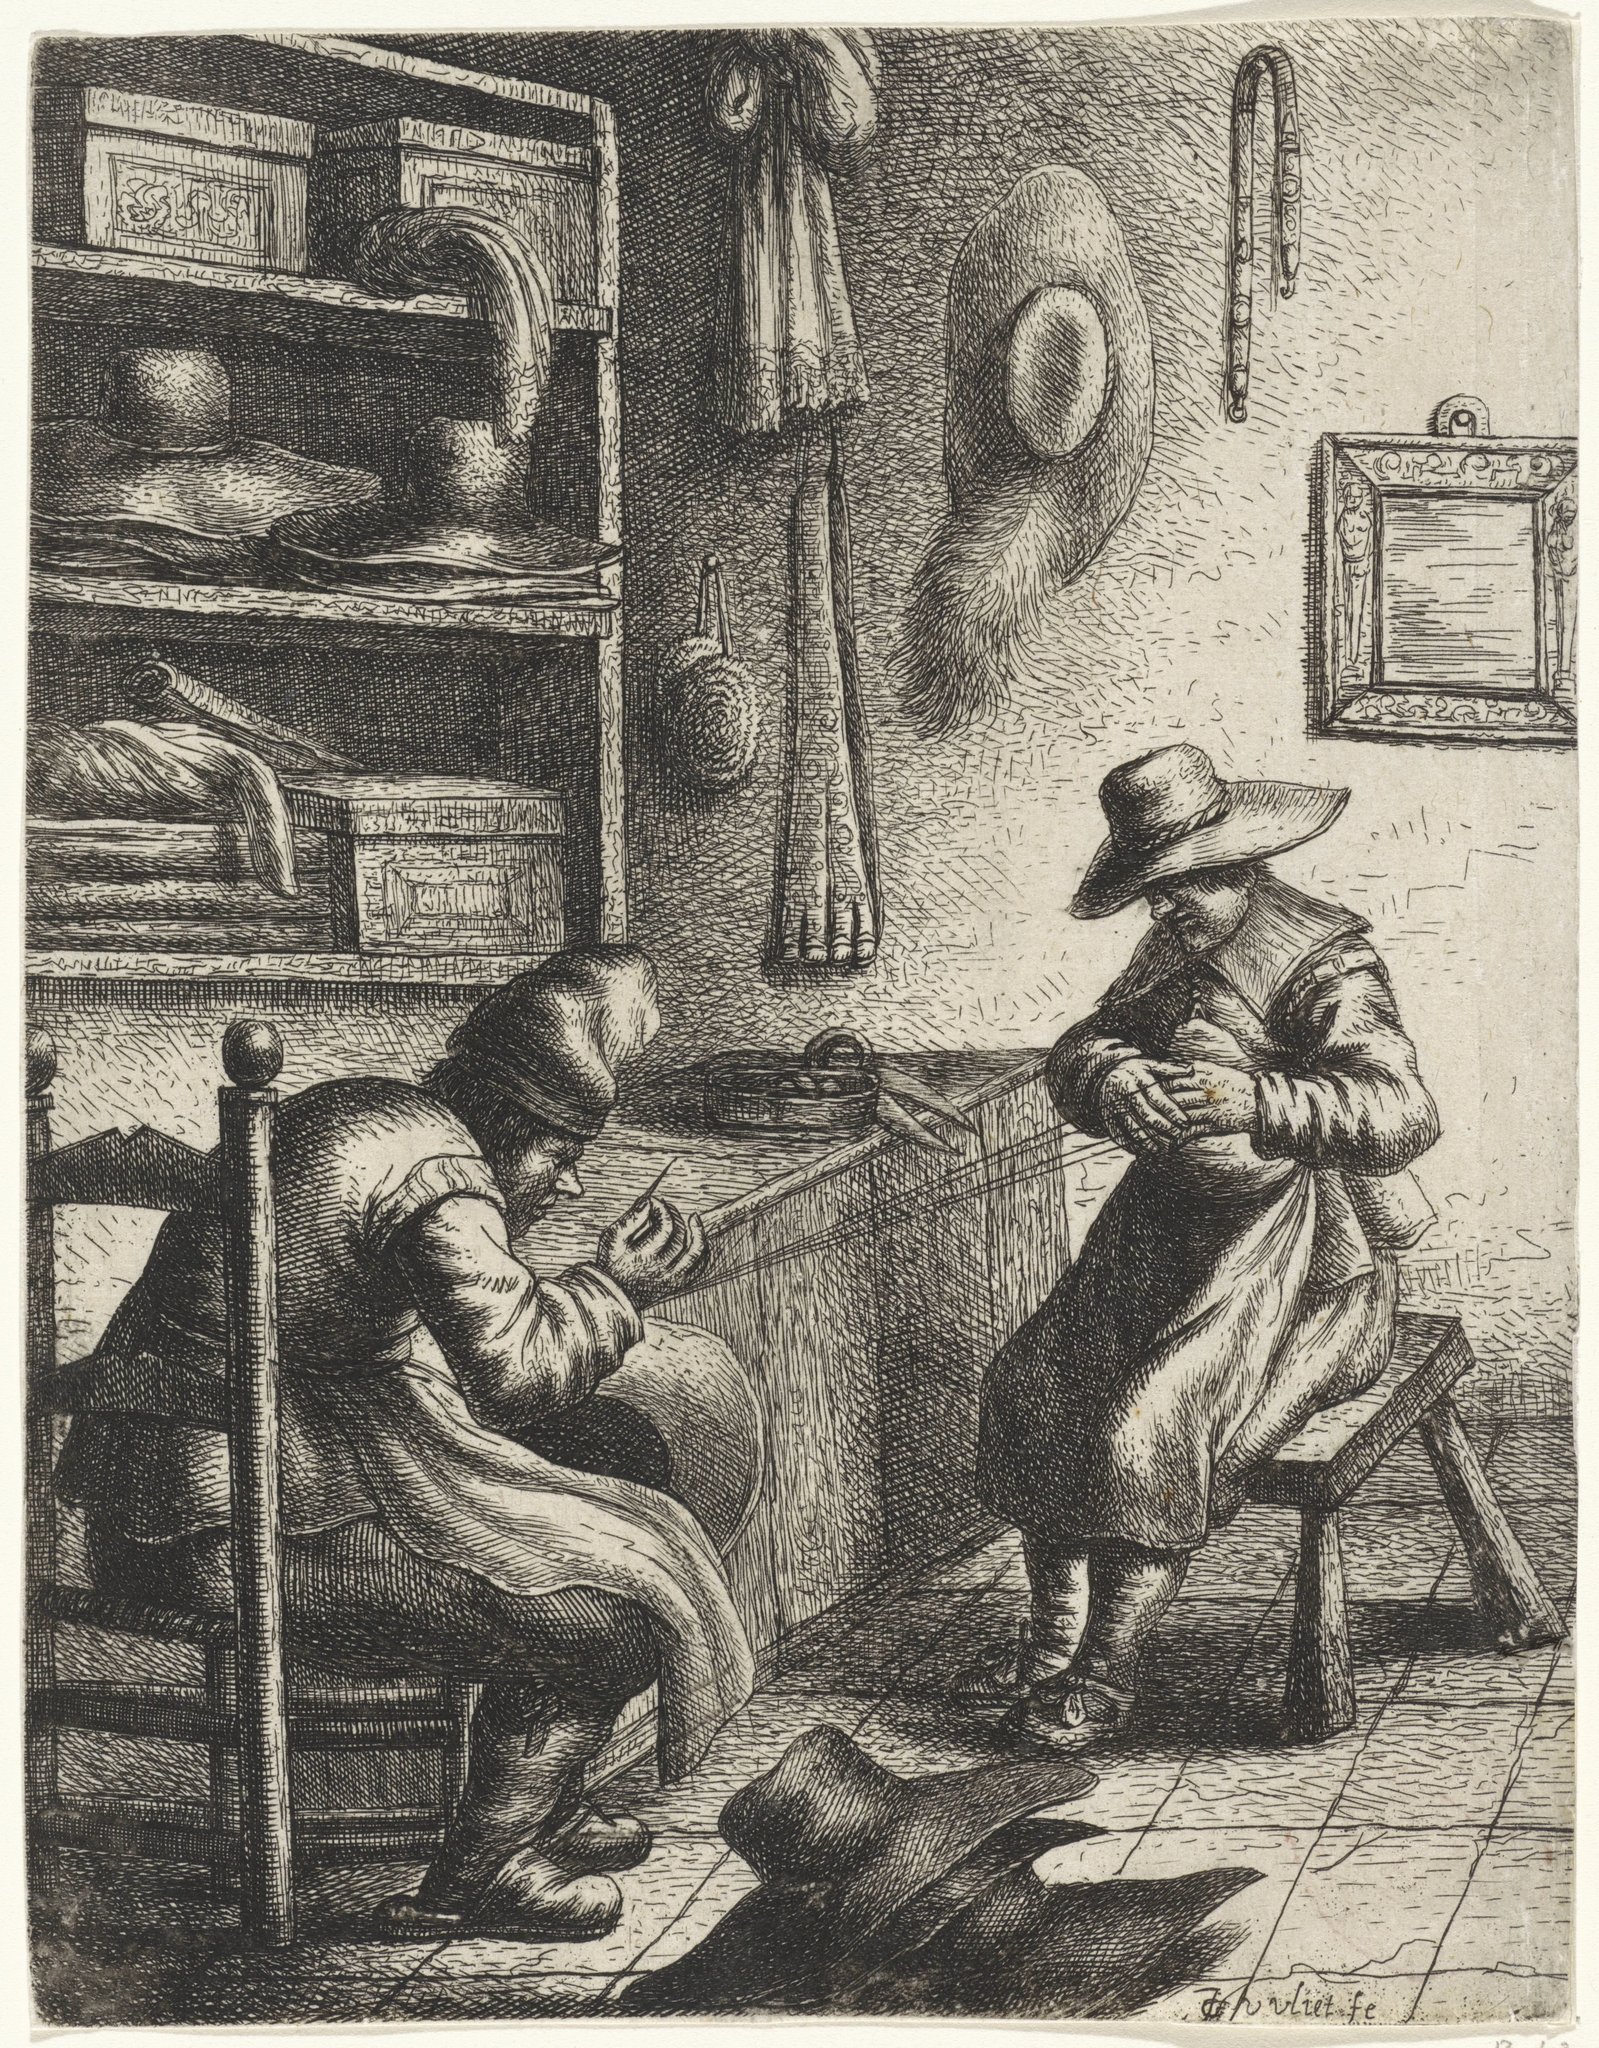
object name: print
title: Beroepen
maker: jan gillisz. van vliet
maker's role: draughtsman, painter, print maker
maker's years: 1600-1668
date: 1635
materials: paper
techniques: etching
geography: leiden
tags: mirror, head-gear: hat (+ men's clothes), hatter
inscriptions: collector's mark: Lugt 240